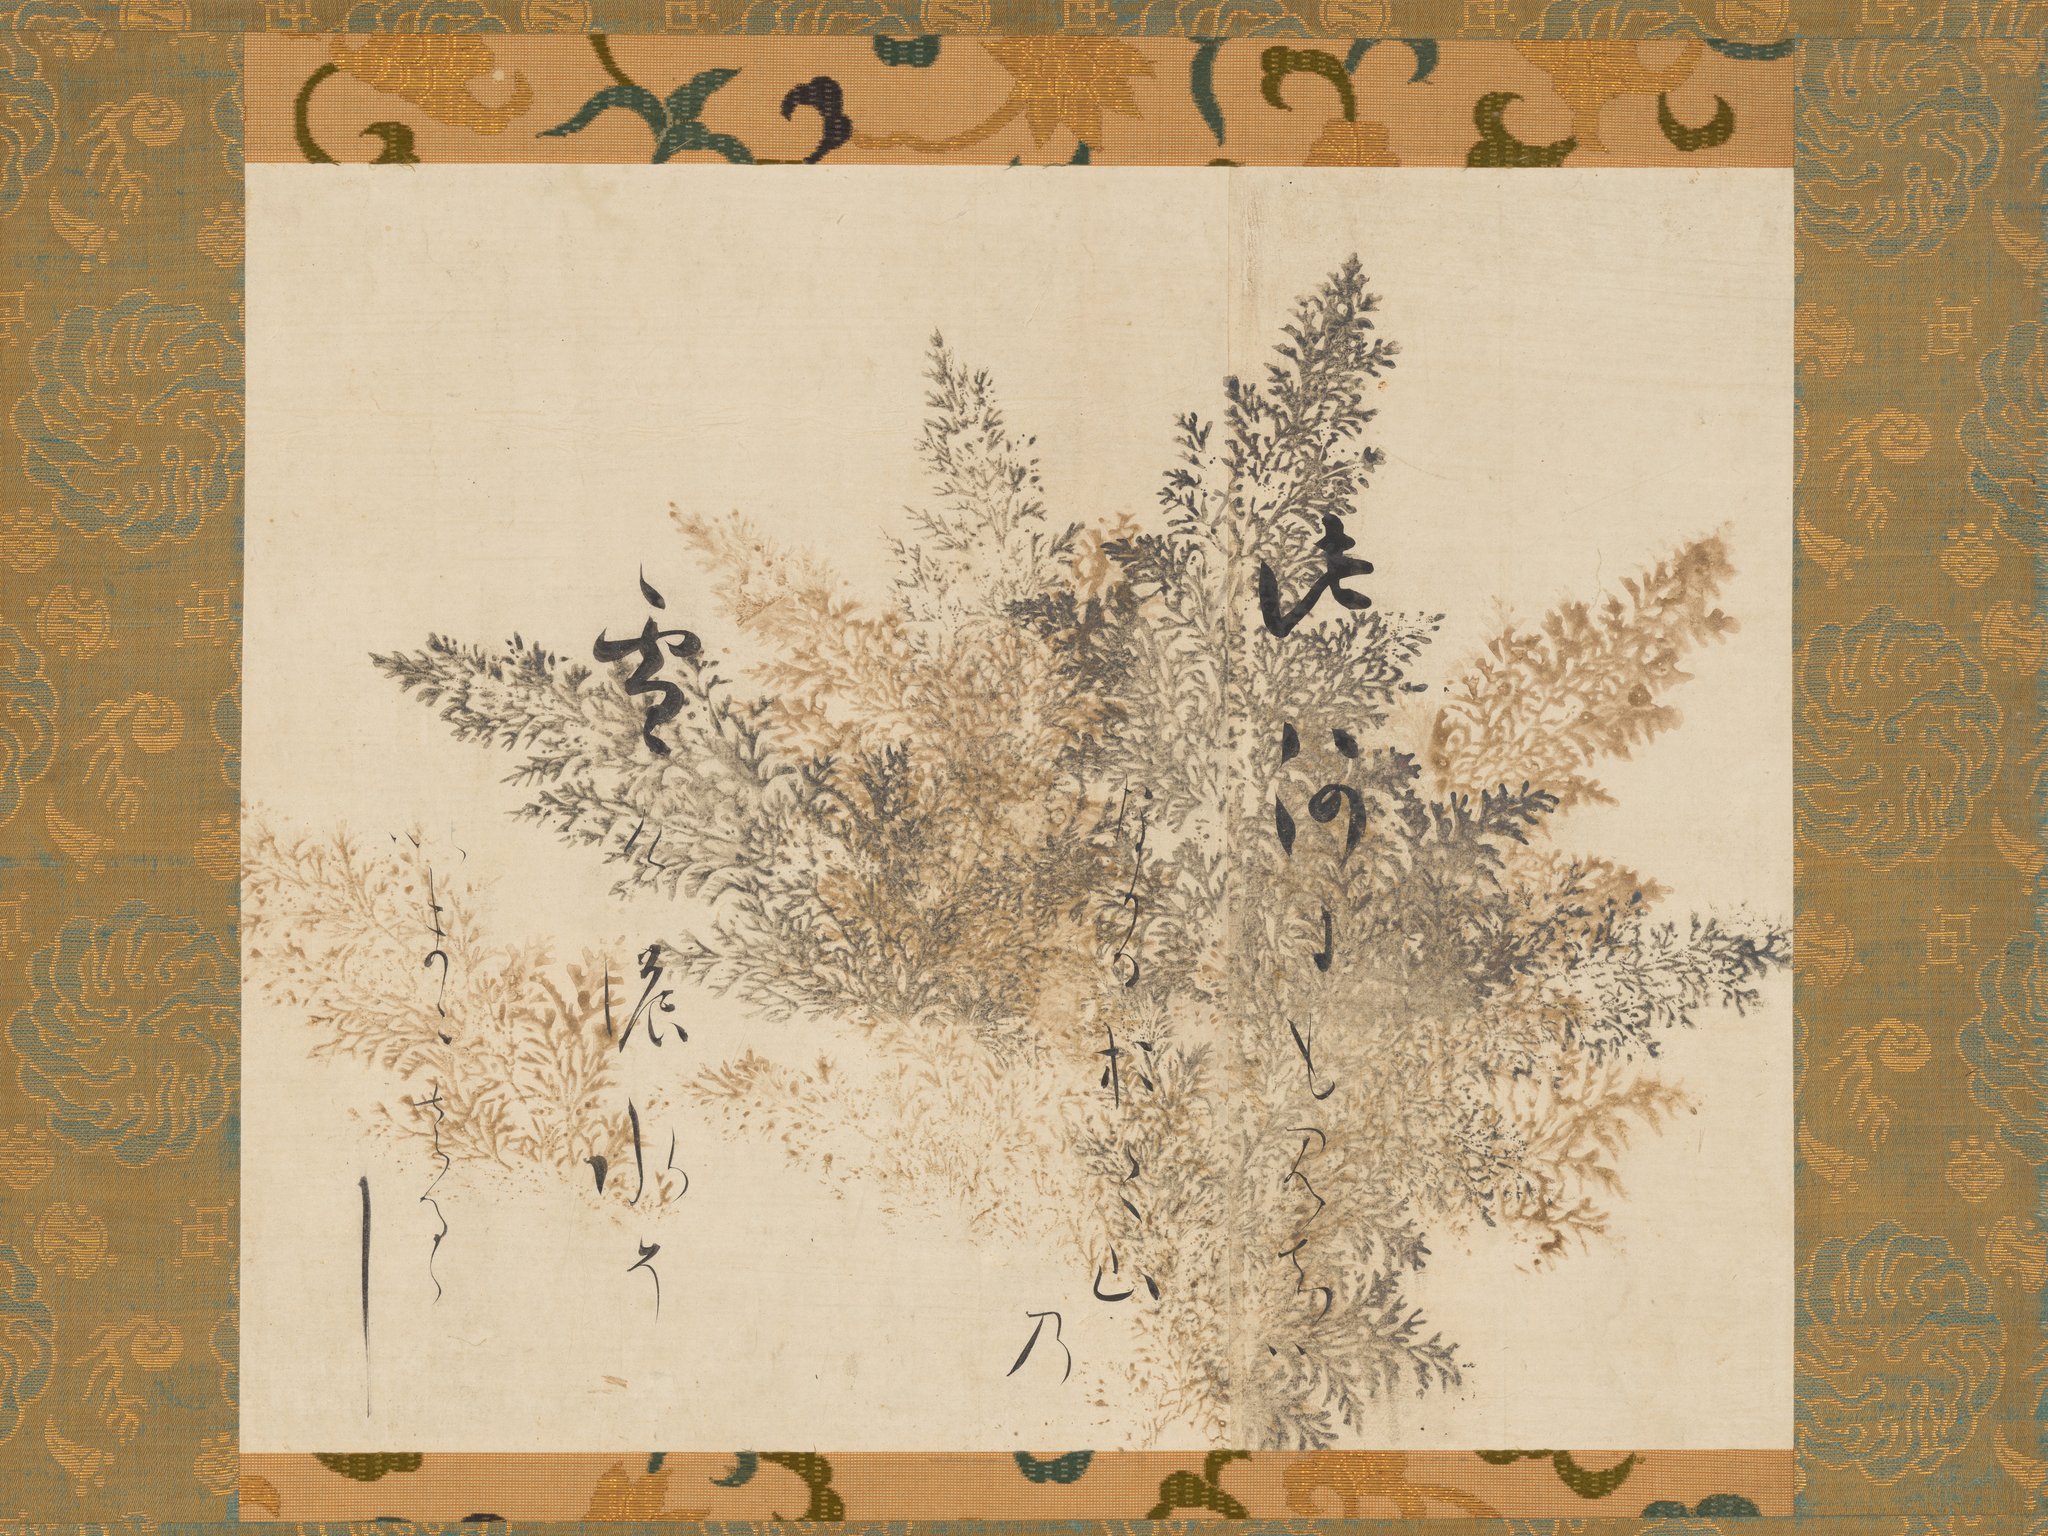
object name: hanging scroll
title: Waka Poem from Collection of Poems Ancient and Modern with a Design of Moss Ferns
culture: japanese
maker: hon'ami kōetsu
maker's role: artist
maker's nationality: japanese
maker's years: 1558-1637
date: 1601-1633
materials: gold, ink, paper, silver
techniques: printing